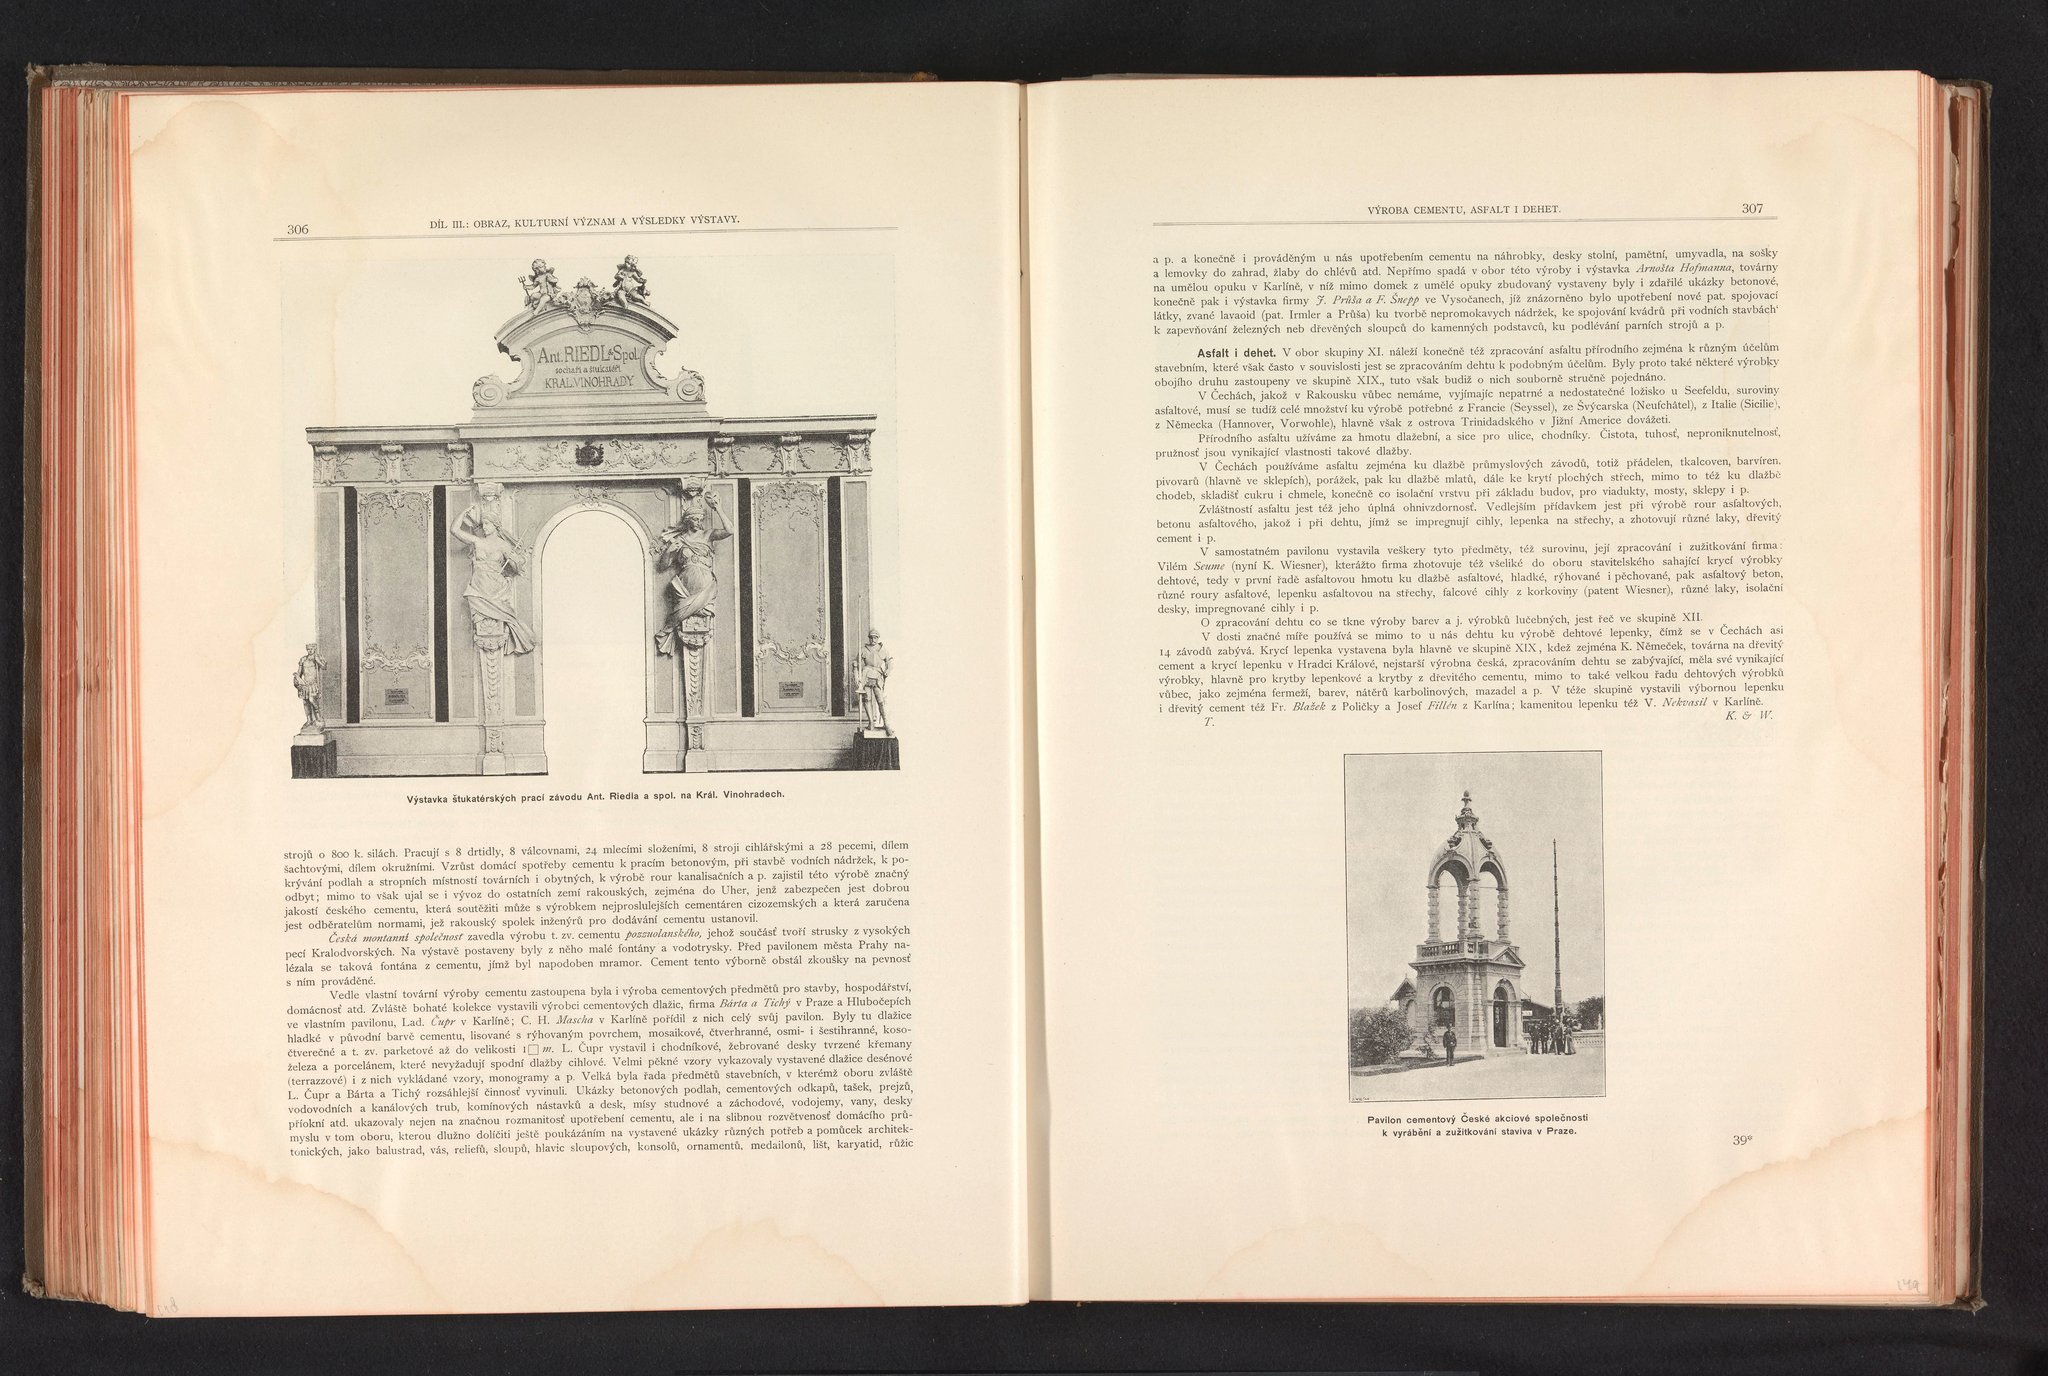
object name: photomechanical print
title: Pavilon cementový Ceské akciové spolecnosti k vyrábeni a zuzitkováni staviva v Praze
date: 1890-1895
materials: paper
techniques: autotype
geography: prague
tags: façade (of house or building)